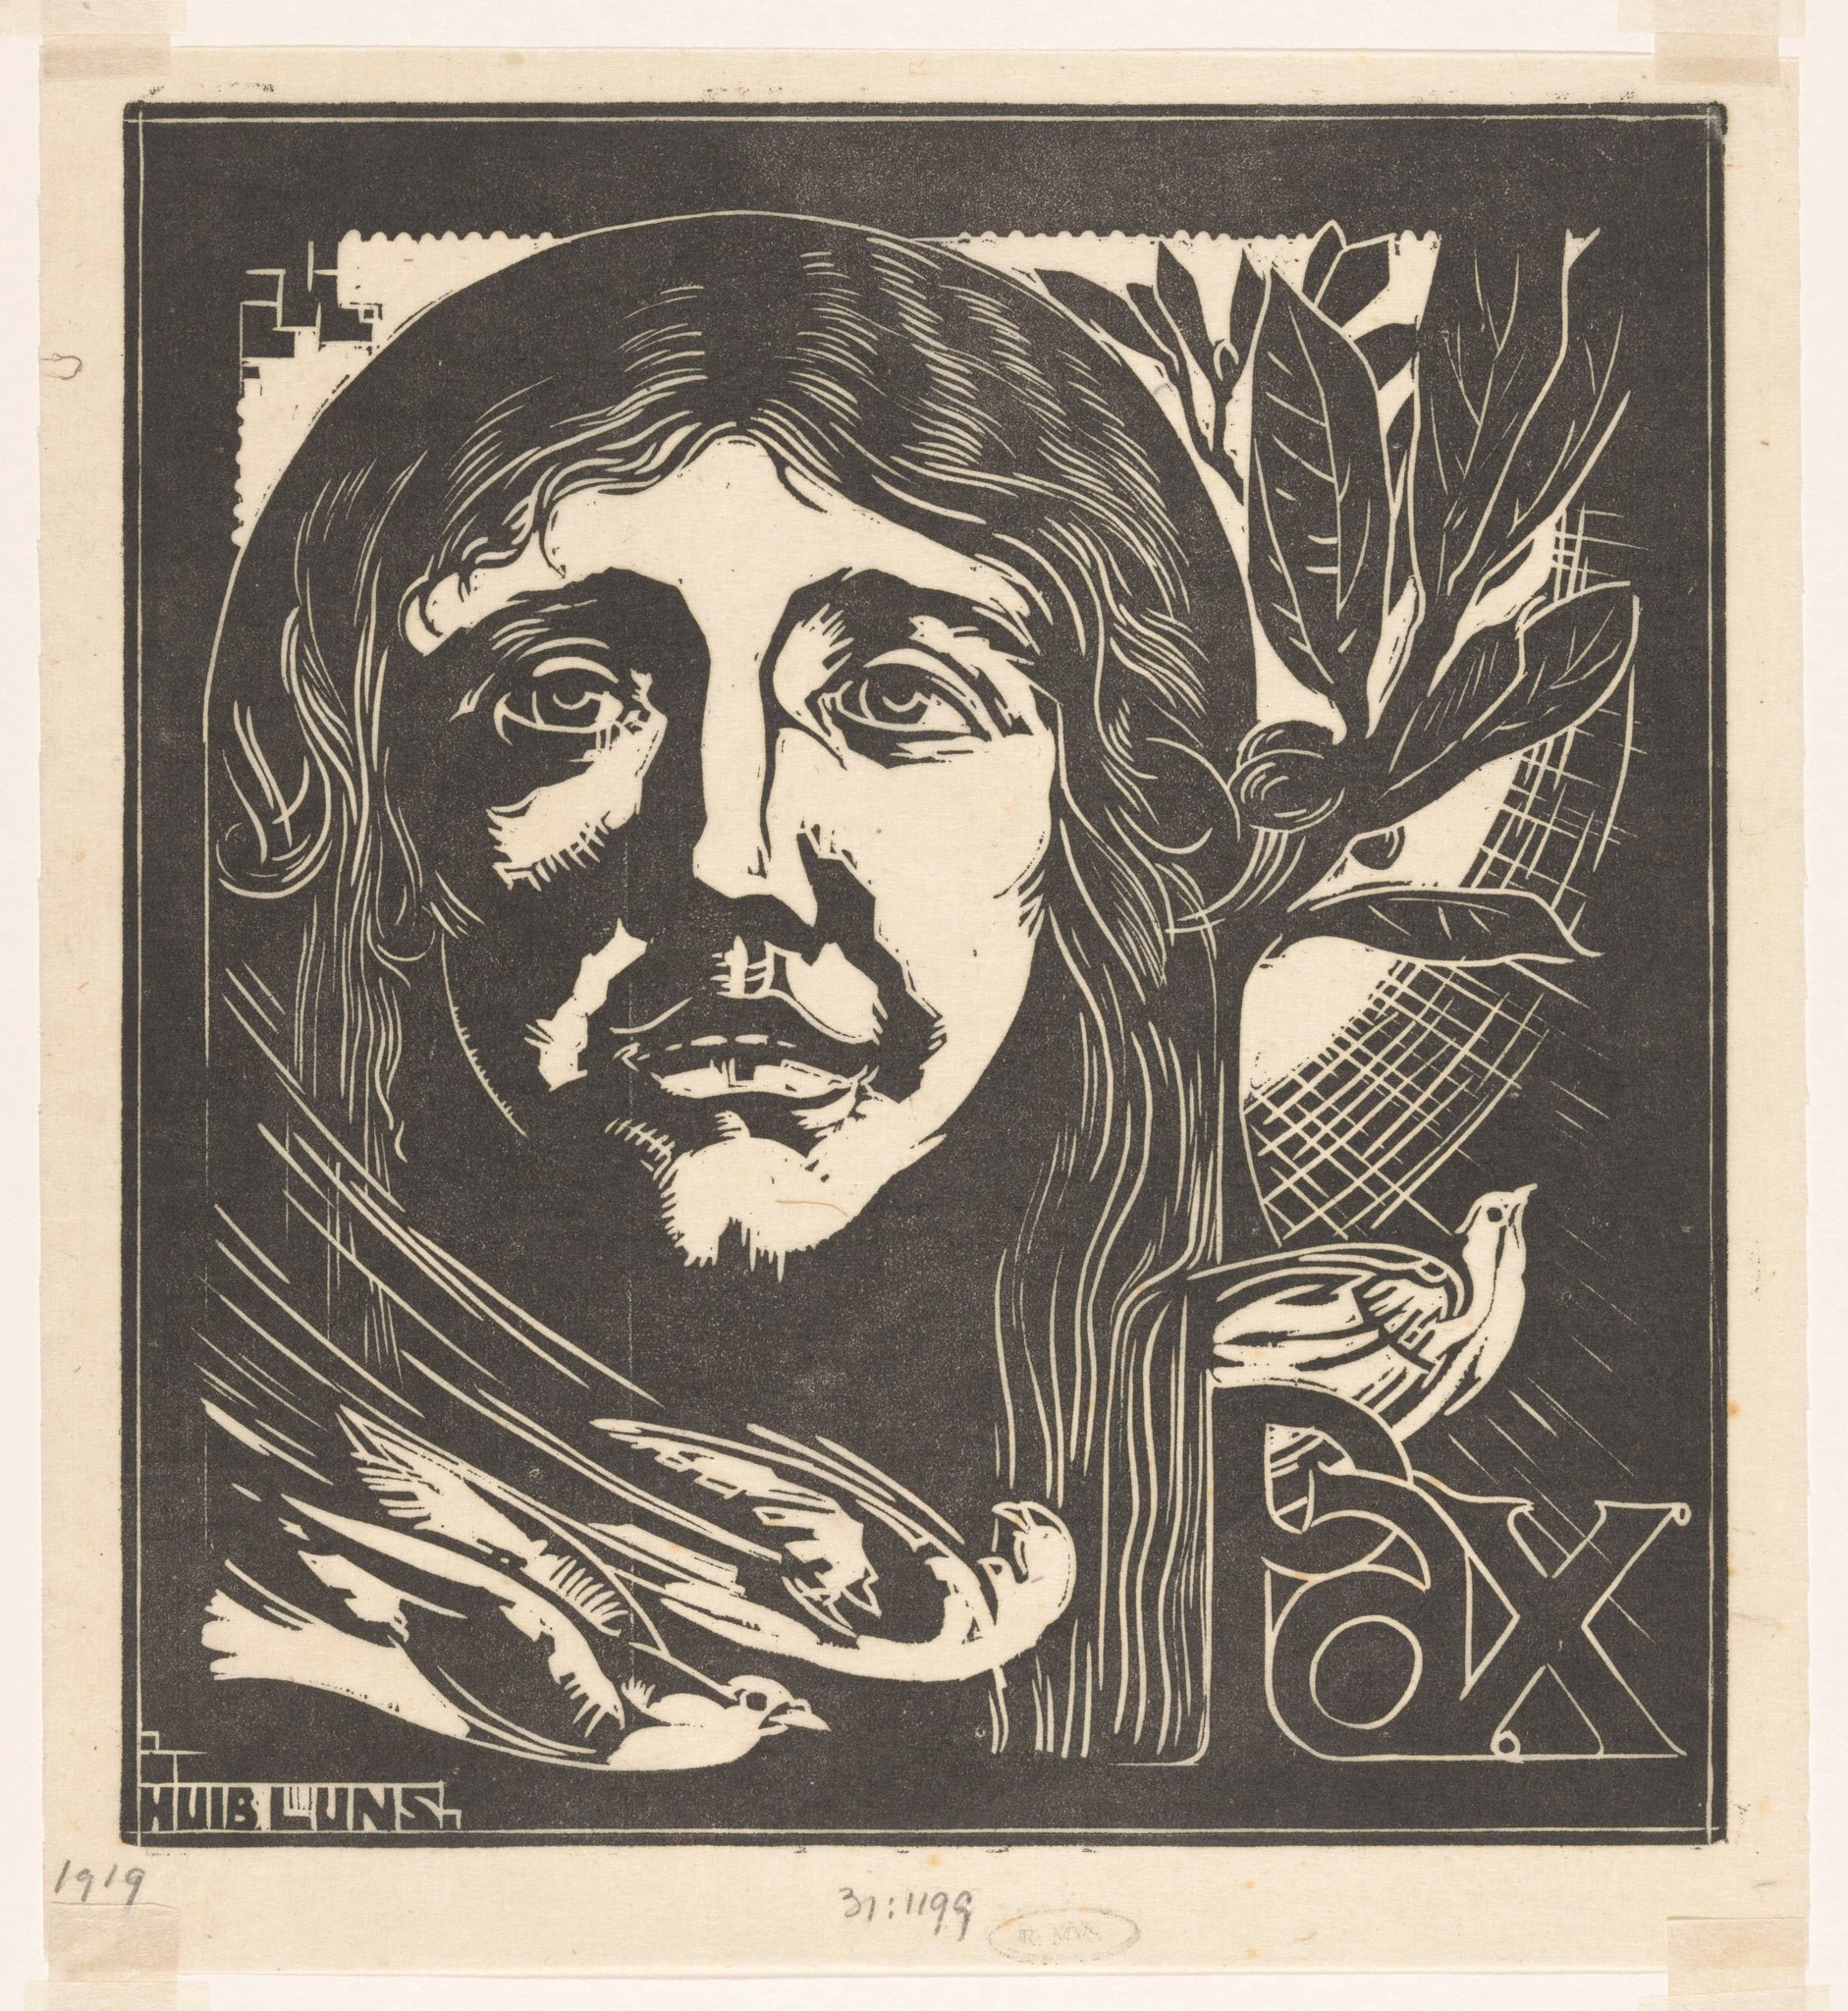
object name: print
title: Pax met duiven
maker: huib luns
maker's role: draughtsman, print maker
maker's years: 1881-1942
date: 1919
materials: paper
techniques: woodcut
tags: symbols, allegories of peace, 'pax'; 'pace' (ripa), pax as roman personification, doves, pigeons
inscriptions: collector's mark: Lugt 2228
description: Het gezicht van Pax. Onder haar gezicht drie duiven, naast haar een olijftak.